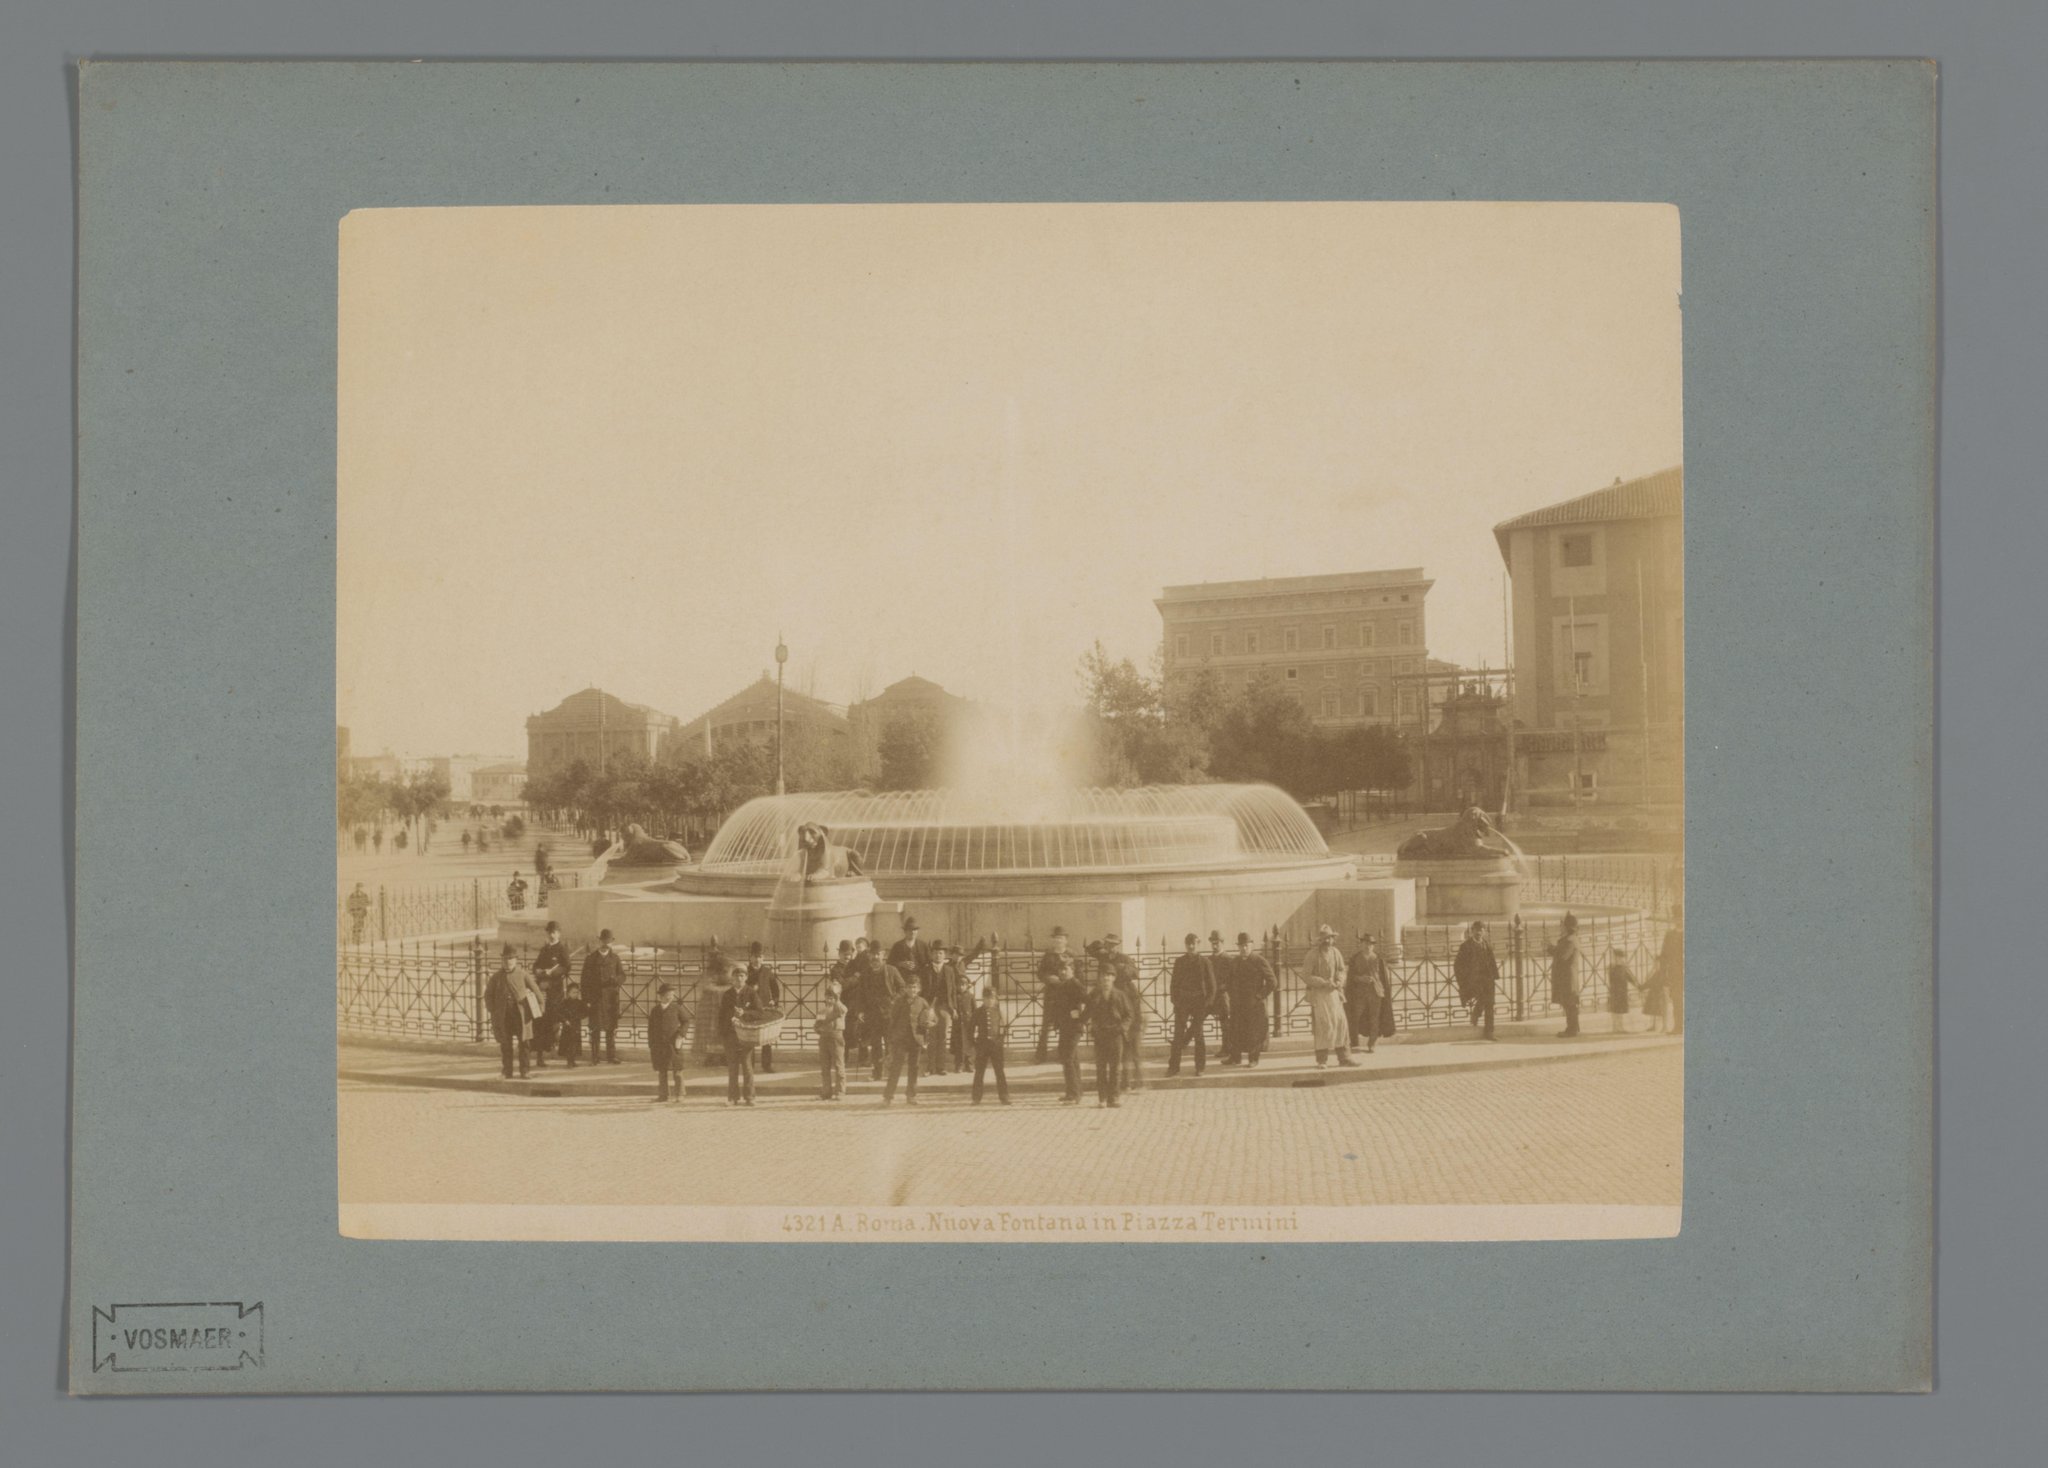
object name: photograph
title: Nuova Fontana in Piazza Termini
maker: Anonymous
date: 1851-1890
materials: cardboard, paper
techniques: albumen print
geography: rome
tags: square, place, circus, etc., ornamental fountain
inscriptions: collector's mark: ‘VOSMAER’, number: ‘4321 A.’